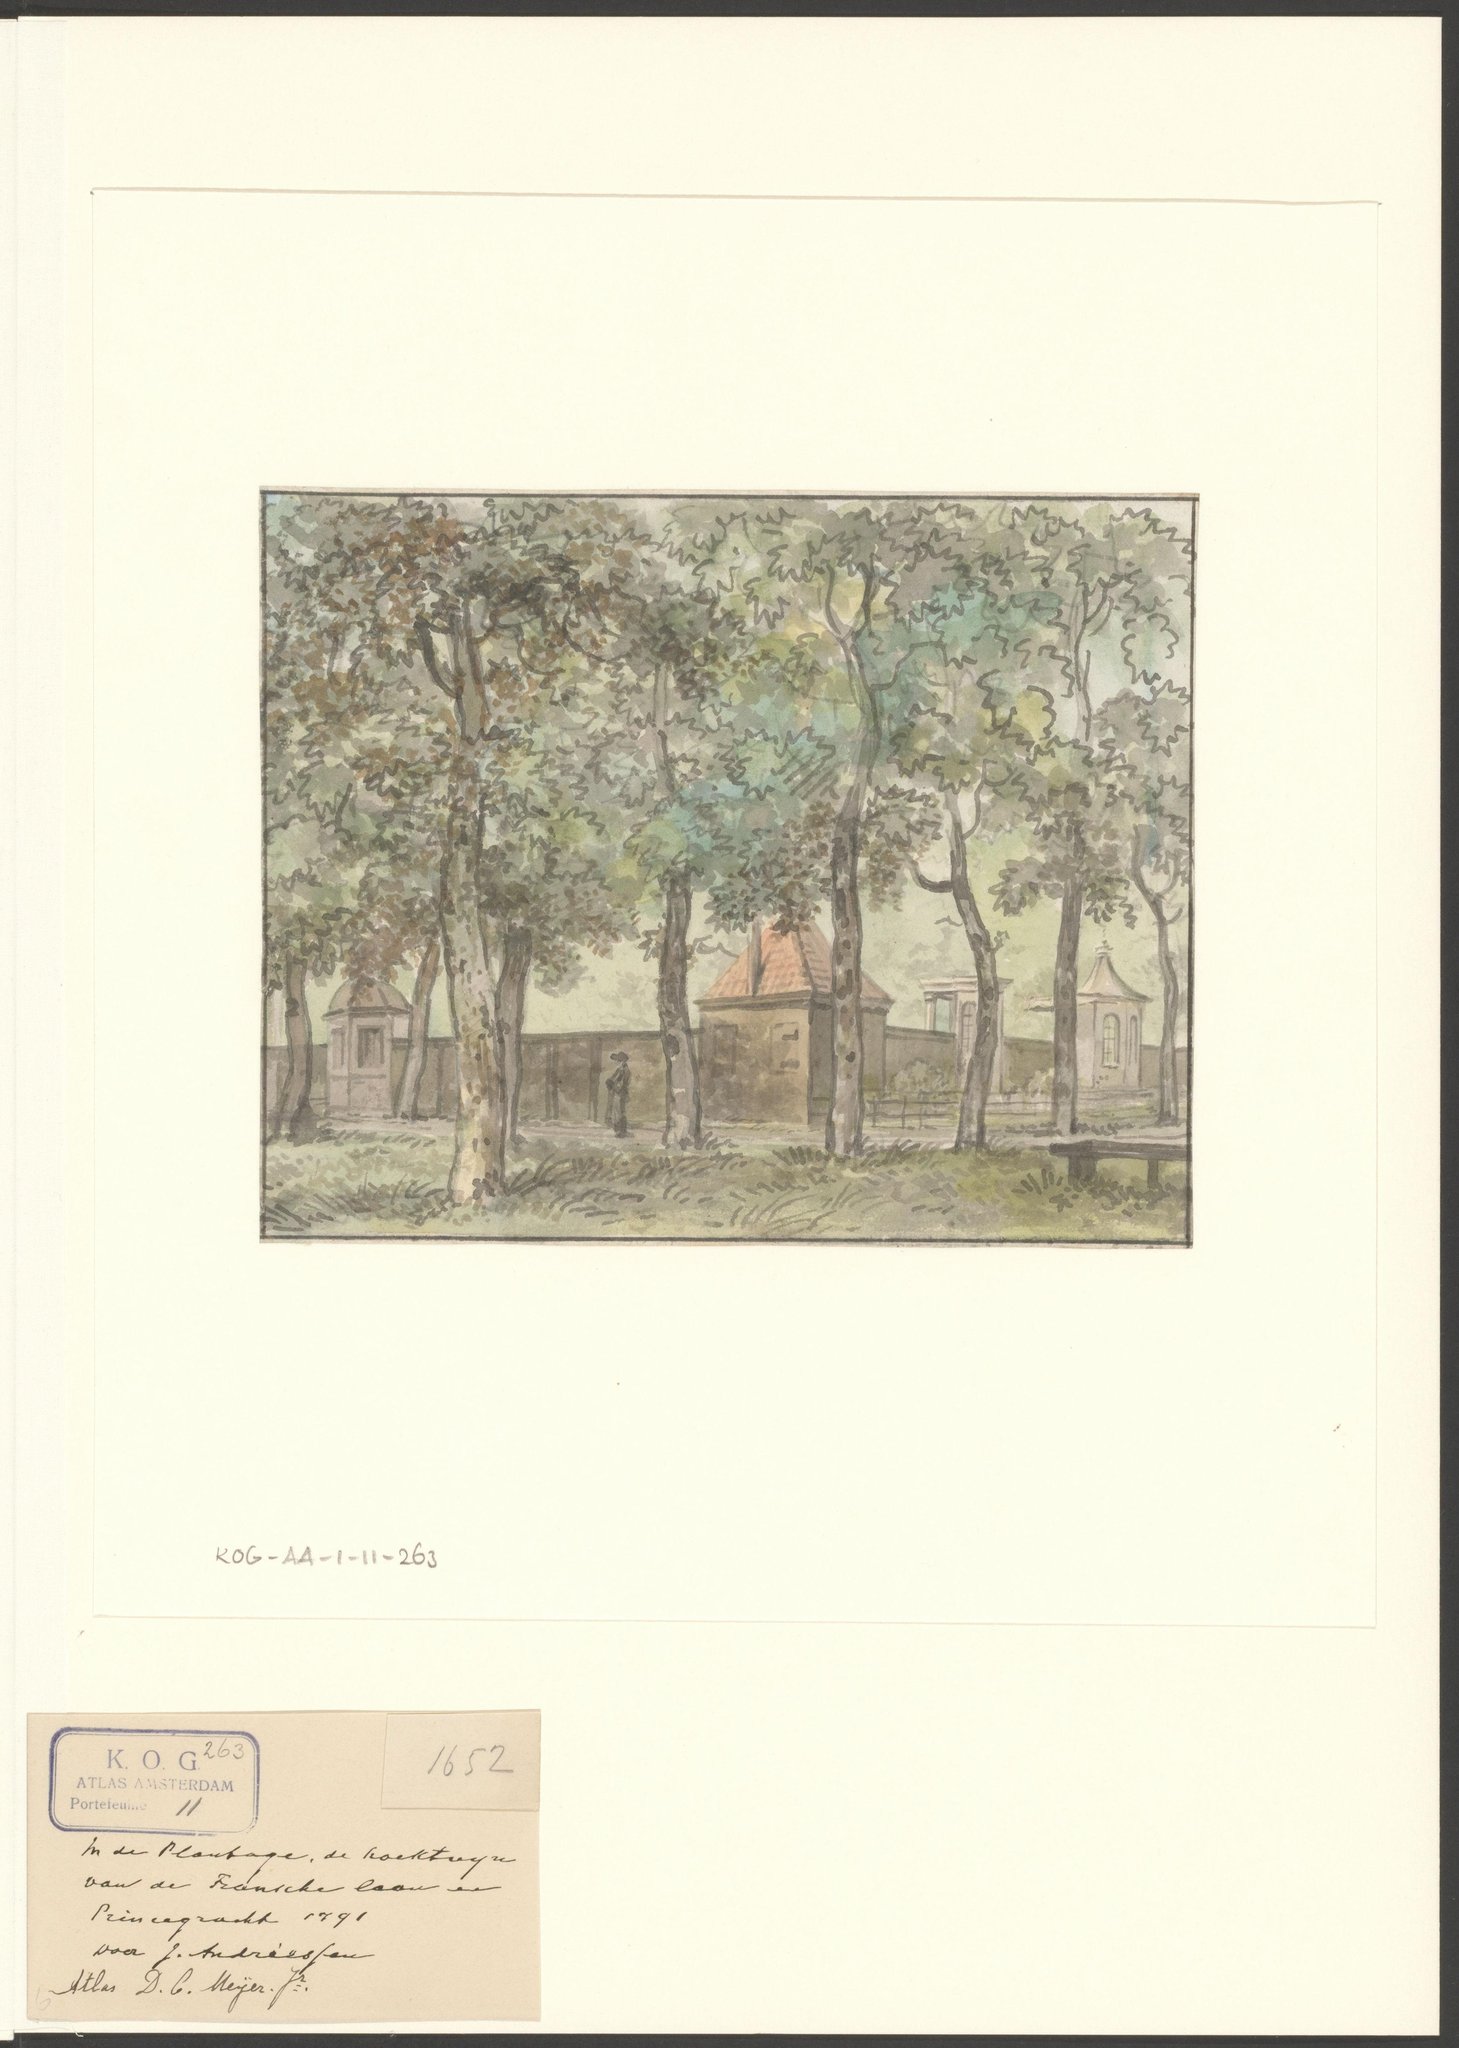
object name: drawing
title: Gezicht op de Plantage Franselaan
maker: jurriaan andriessen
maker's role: draughtsman, painter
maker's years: 1742-1819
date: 1791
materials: paper, watercolor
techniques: brush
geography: amsterdam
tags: city-view in general; 'veduta', road, path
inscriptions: inscription: ‘Port. 11-263’, collector's mark: ‘11’ Lugt 1641b, inscription: ‘inde Plantagie / de (...) en Prinsengragt / 9 18/1 1’, inscription: ‘In de Plantage (...) D.C. Meijer Jr’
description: Onderwerpsrubriek binnen de Atlas Amsterdam: Paleisstraat, Palmgracht, Papenbrugsteeg, Passeerdersgracht, Peperstraat, Pieterspoort (St.), Pieterssteeg (St.), Plantage, Prinseneiland.